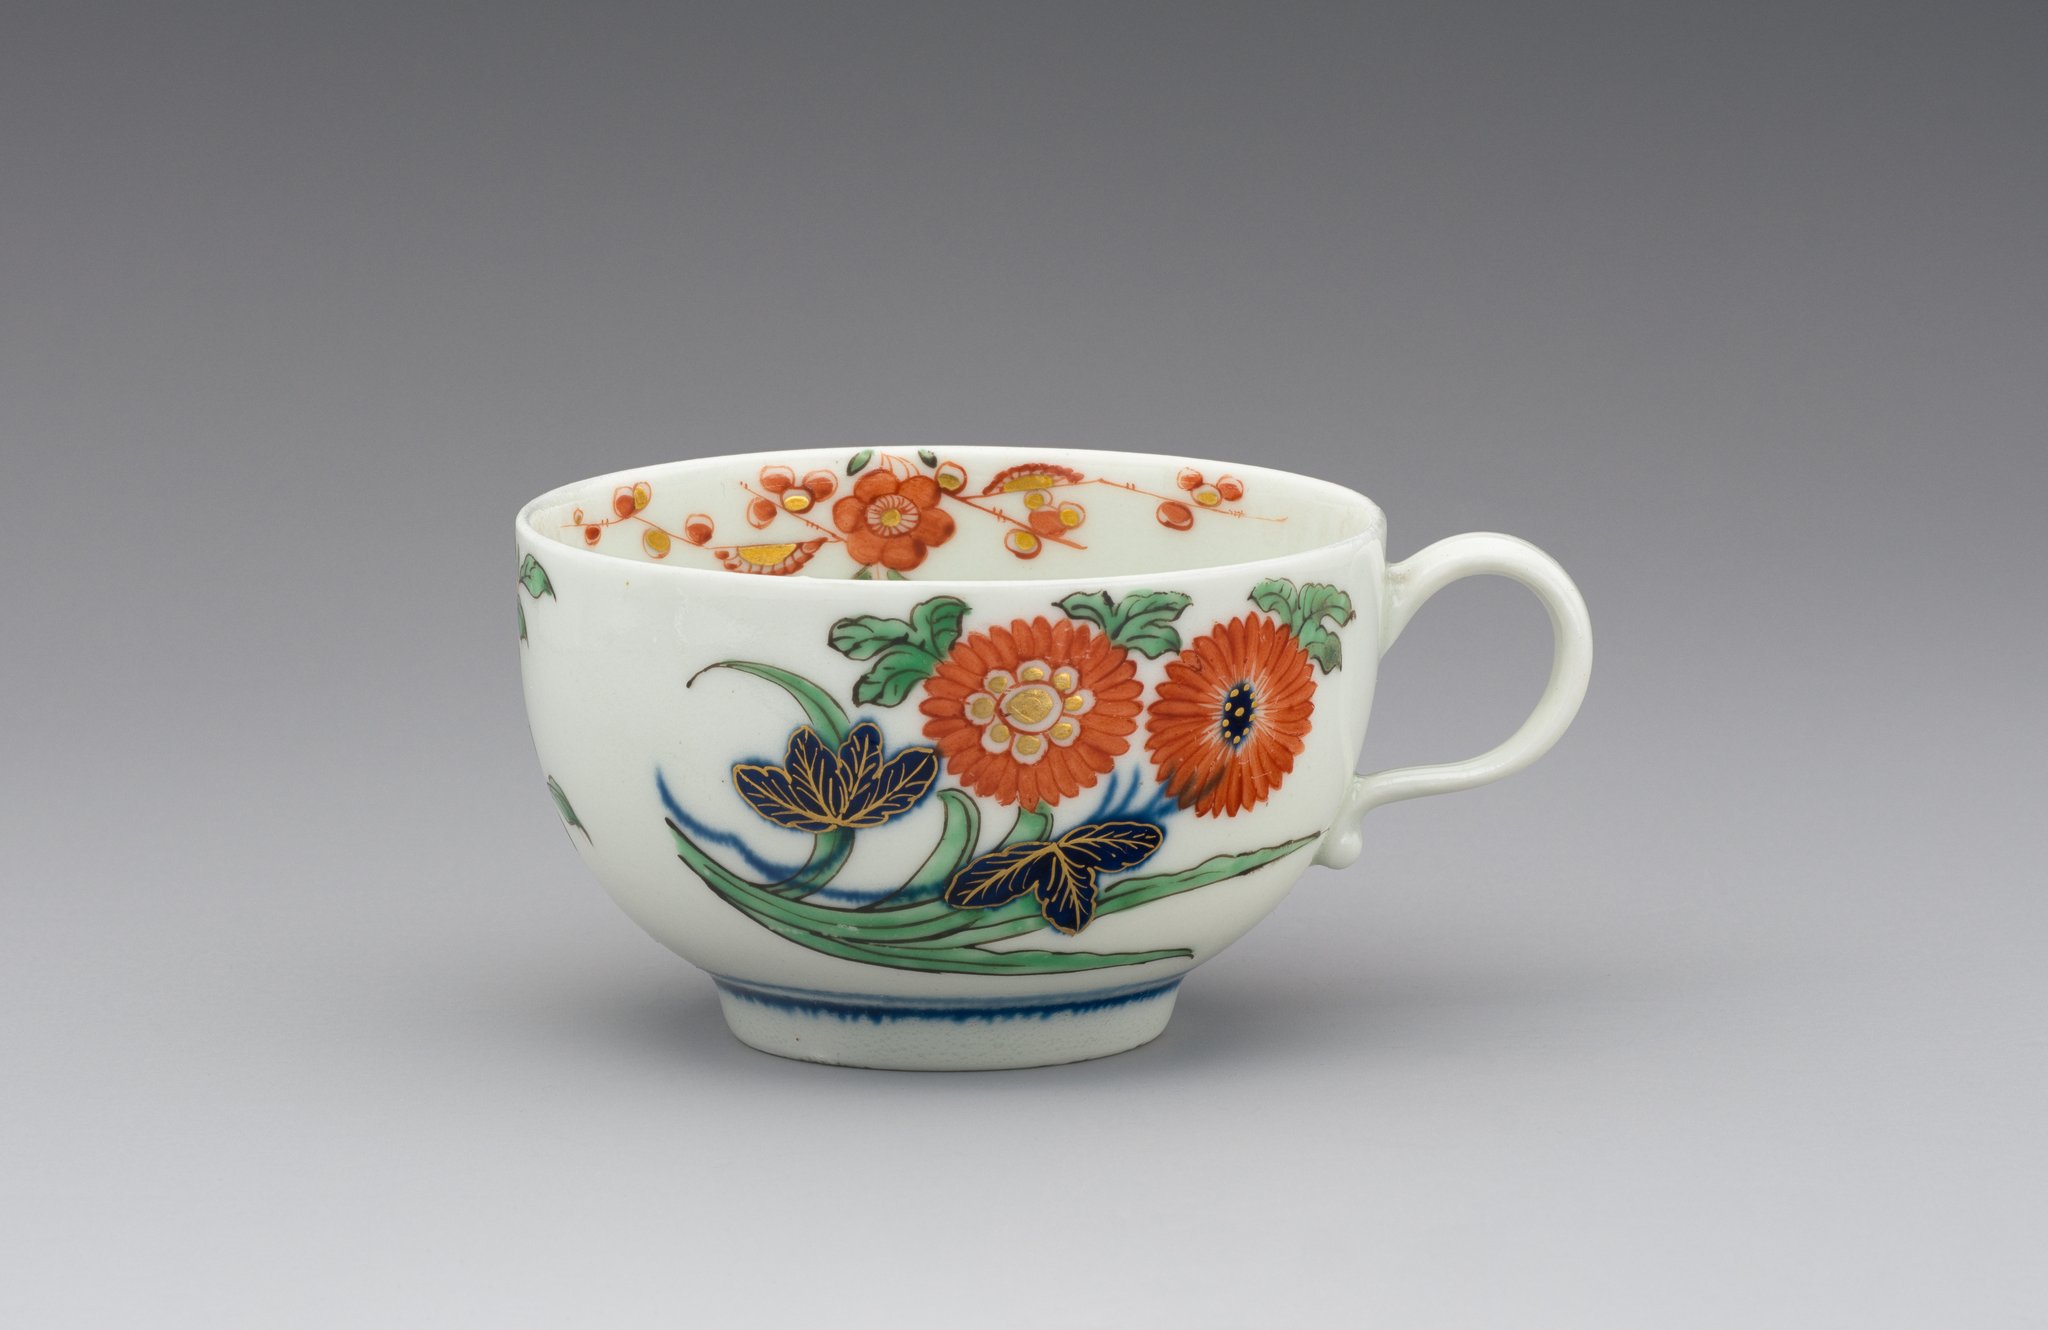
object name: cup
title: Cup (part of a service)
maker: worcester factory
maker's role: factory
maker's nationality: british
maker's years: 1751-2008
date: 1765-1770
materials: soft paste porcelain